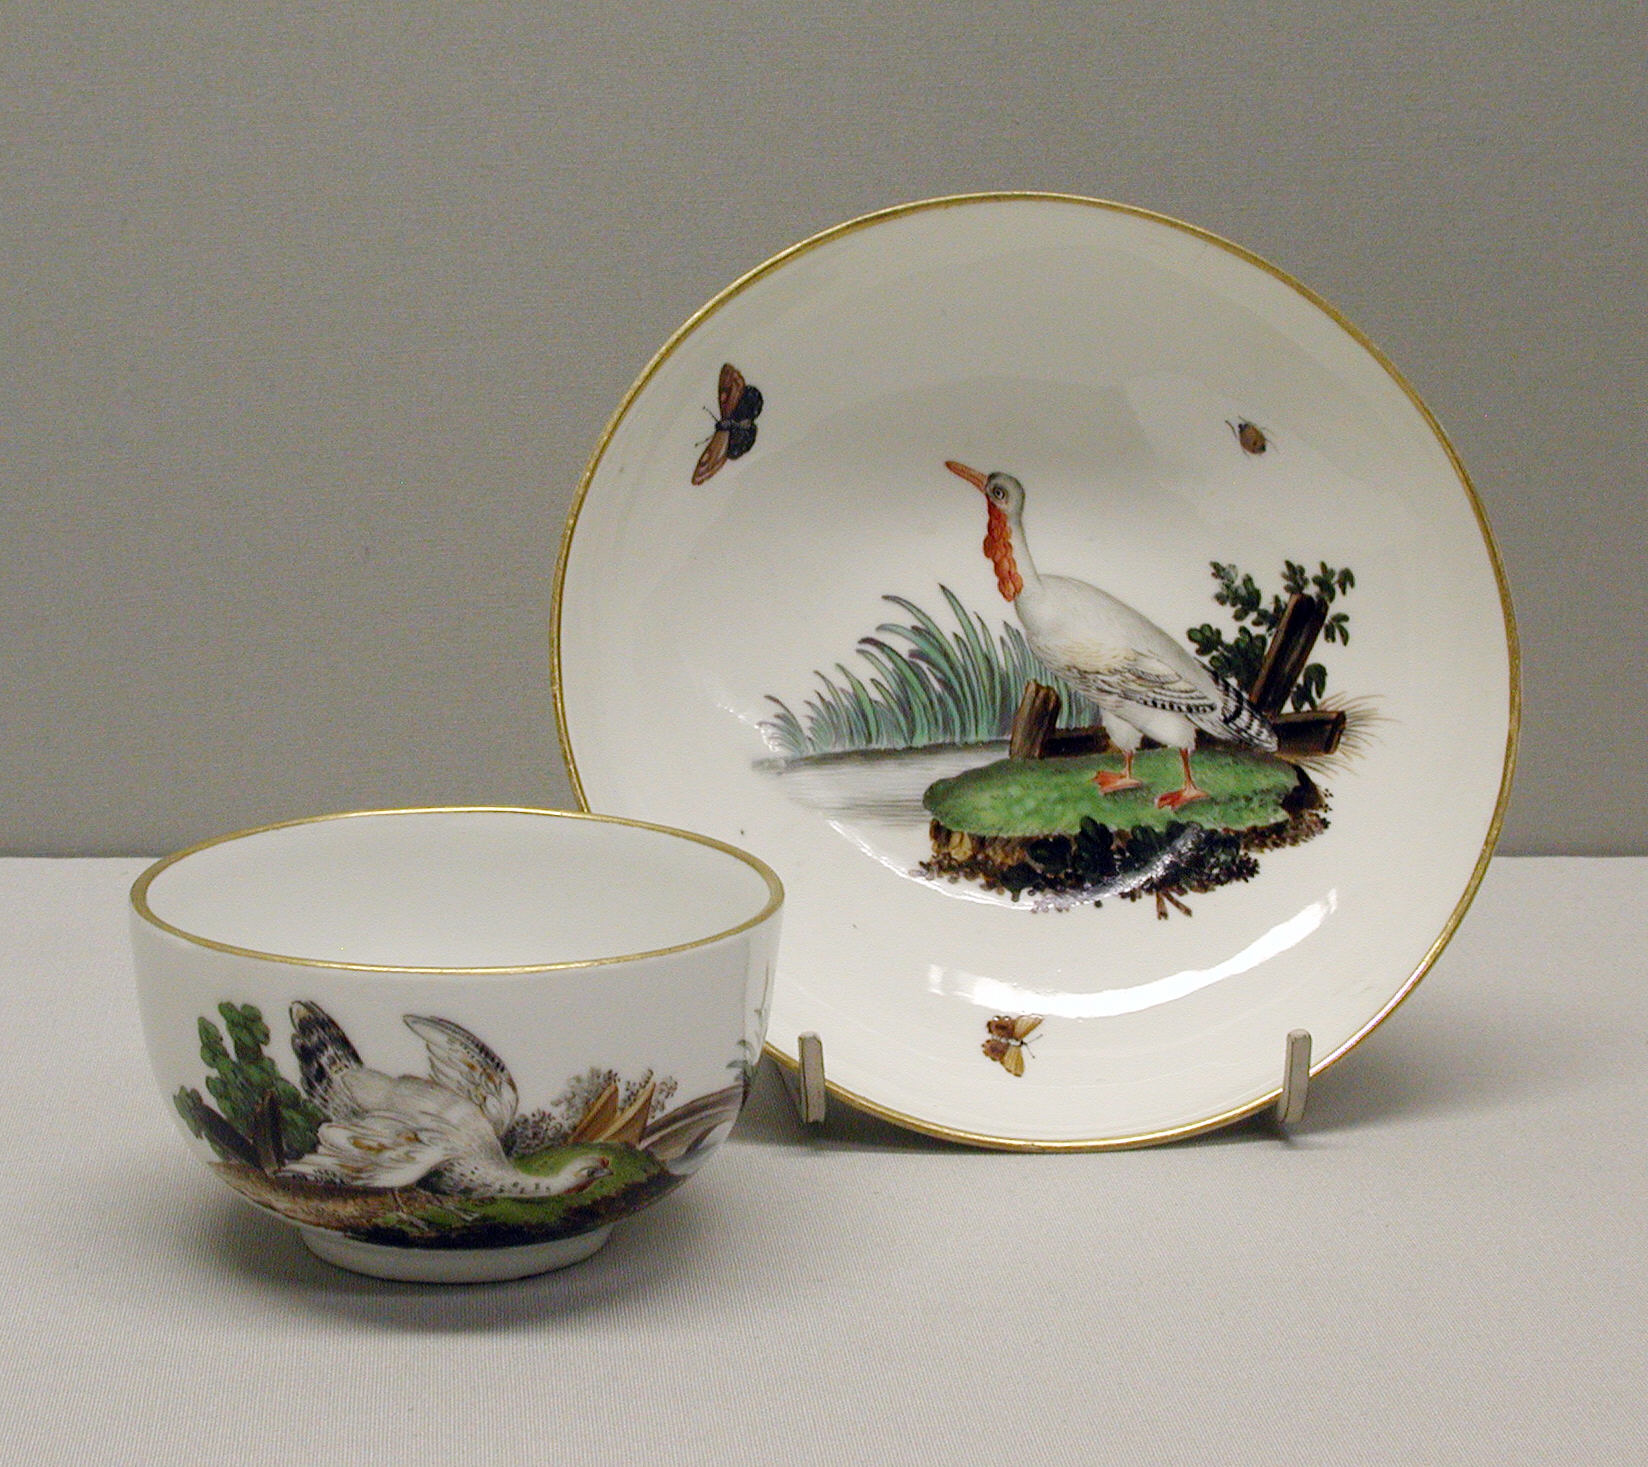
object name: teacup and saucer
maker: höchst manufactory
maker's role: manufactory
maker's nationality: german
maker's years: 1746-1796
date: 1775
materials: hard paste porcelain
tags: birds,butterflies